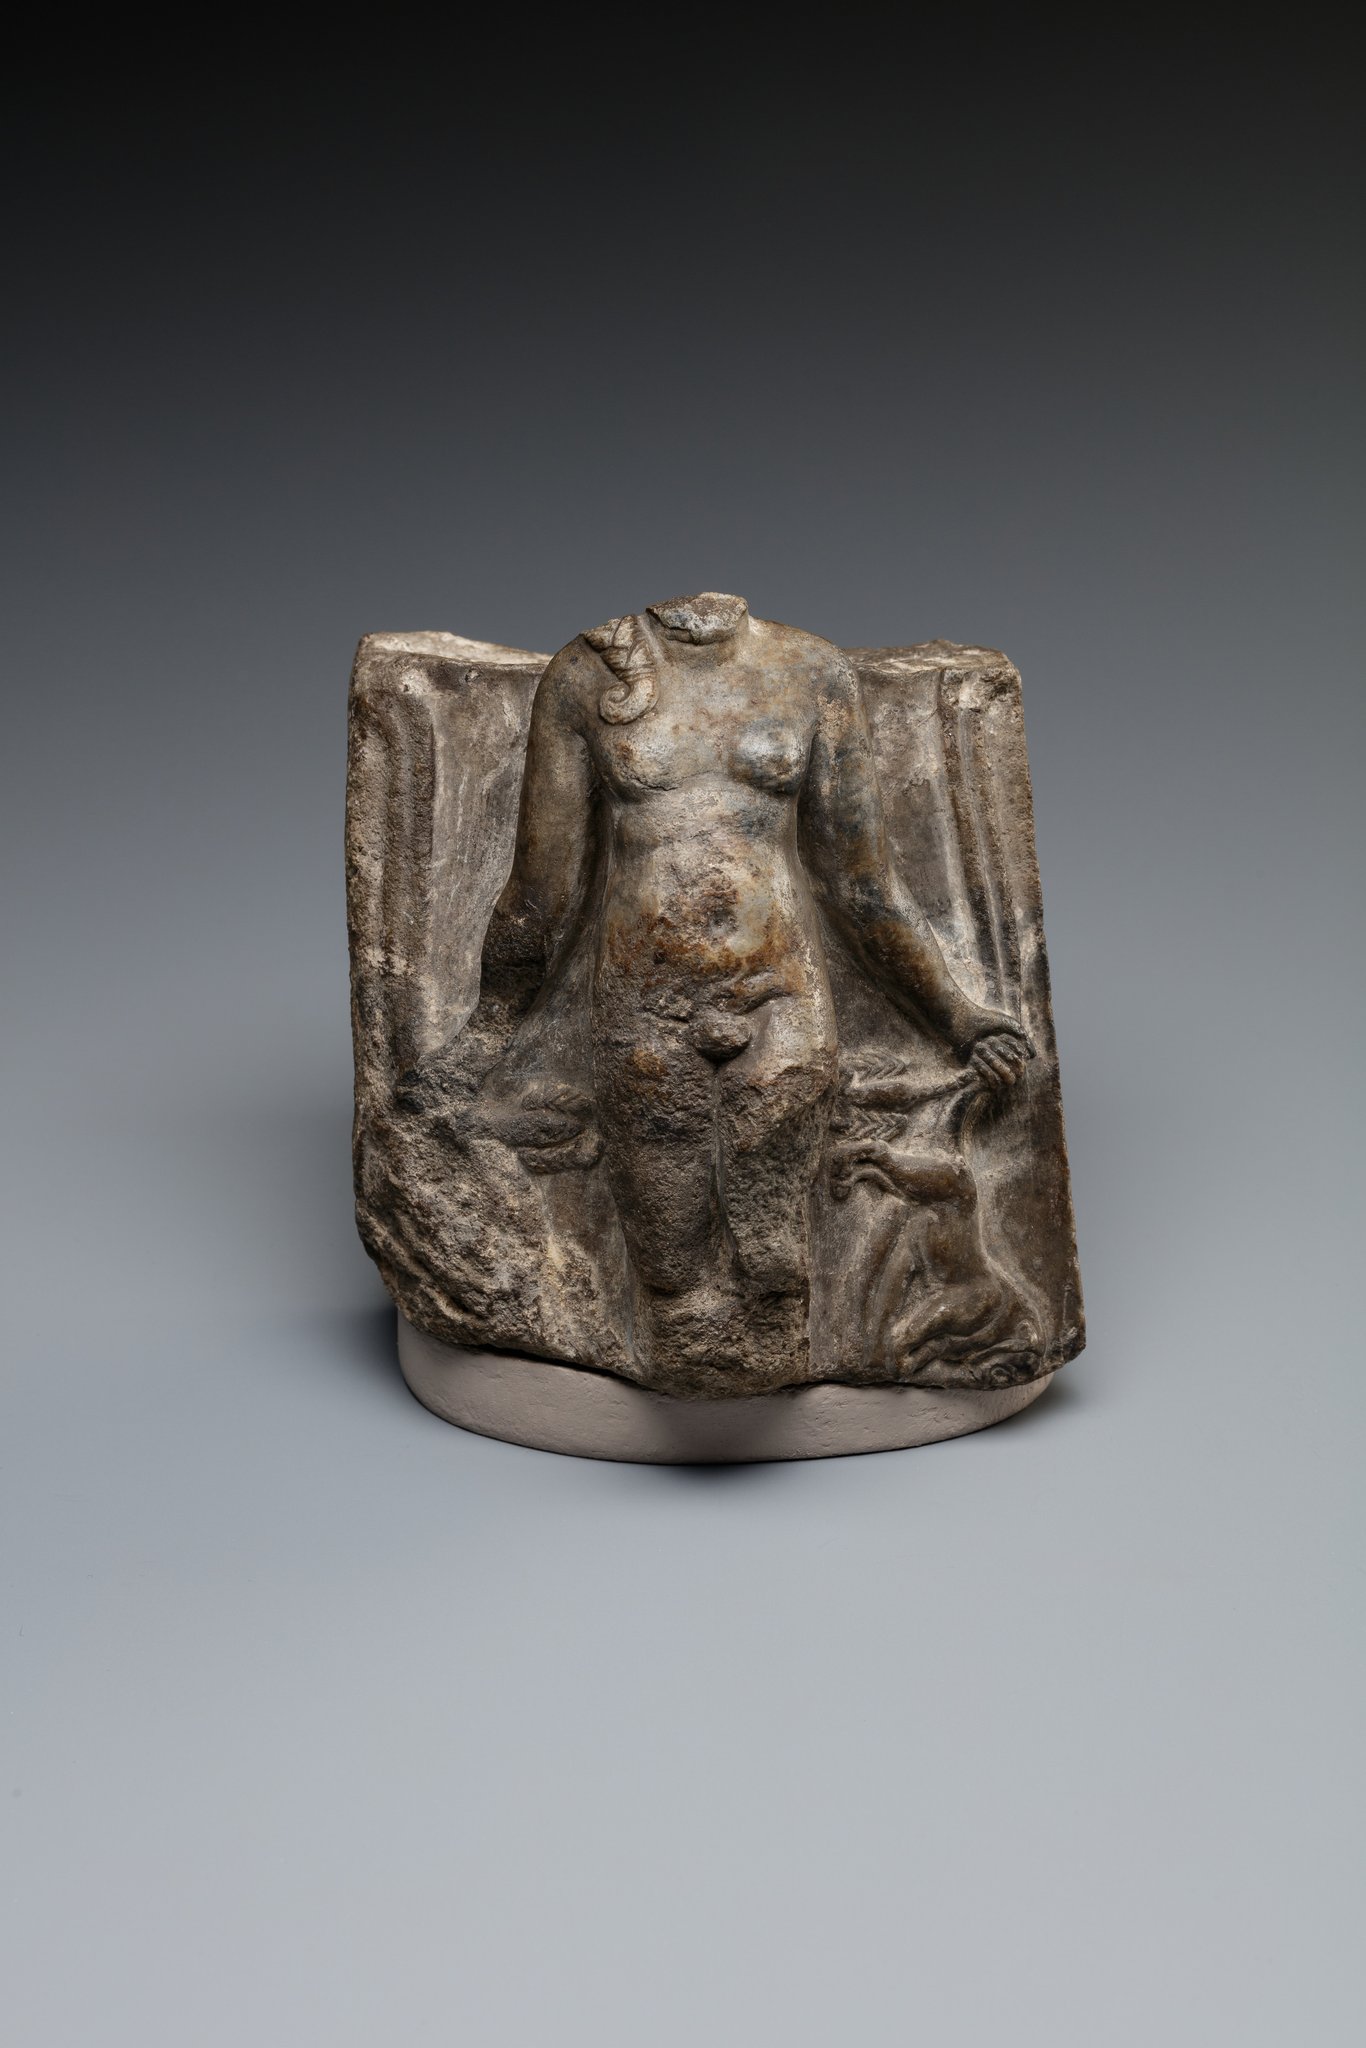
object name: cippus, horus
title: Cippus of Horus (magical stela)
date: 332-330 BCE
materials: marble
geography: egypt